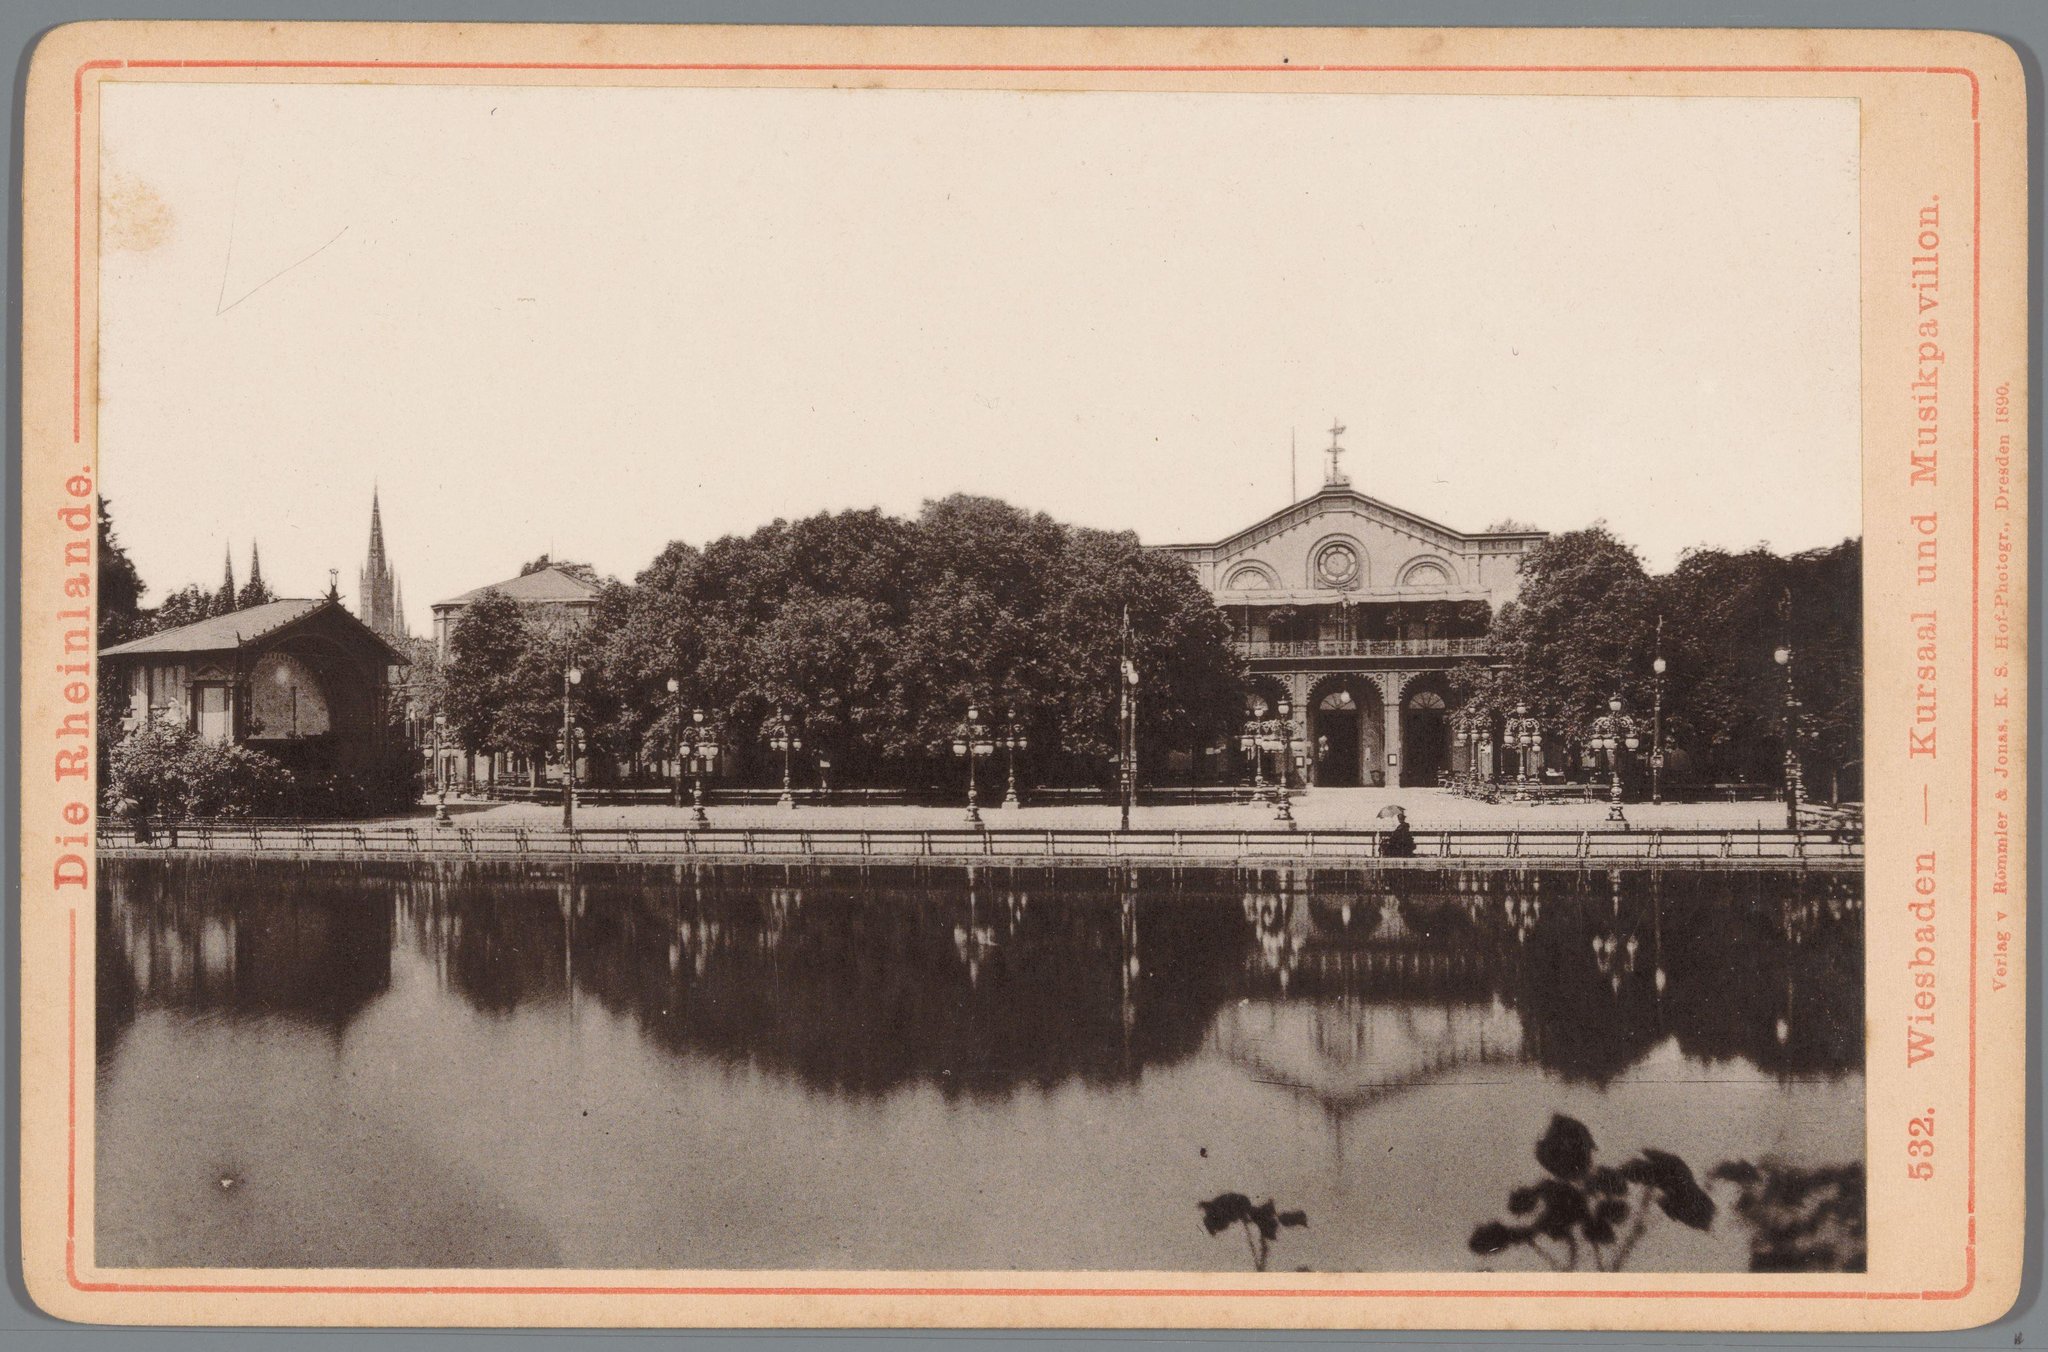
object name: photomechanical print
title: Gezicht op het kurhaus en een muziektent in Wiesbaden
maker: Anonymous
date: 1890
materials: cardboard, paper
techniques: photograph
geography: wiesbaden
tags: bandstand, watering-place, spa, pond, pool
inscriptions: number: ‘532.’, name: ‘Vosmaer’